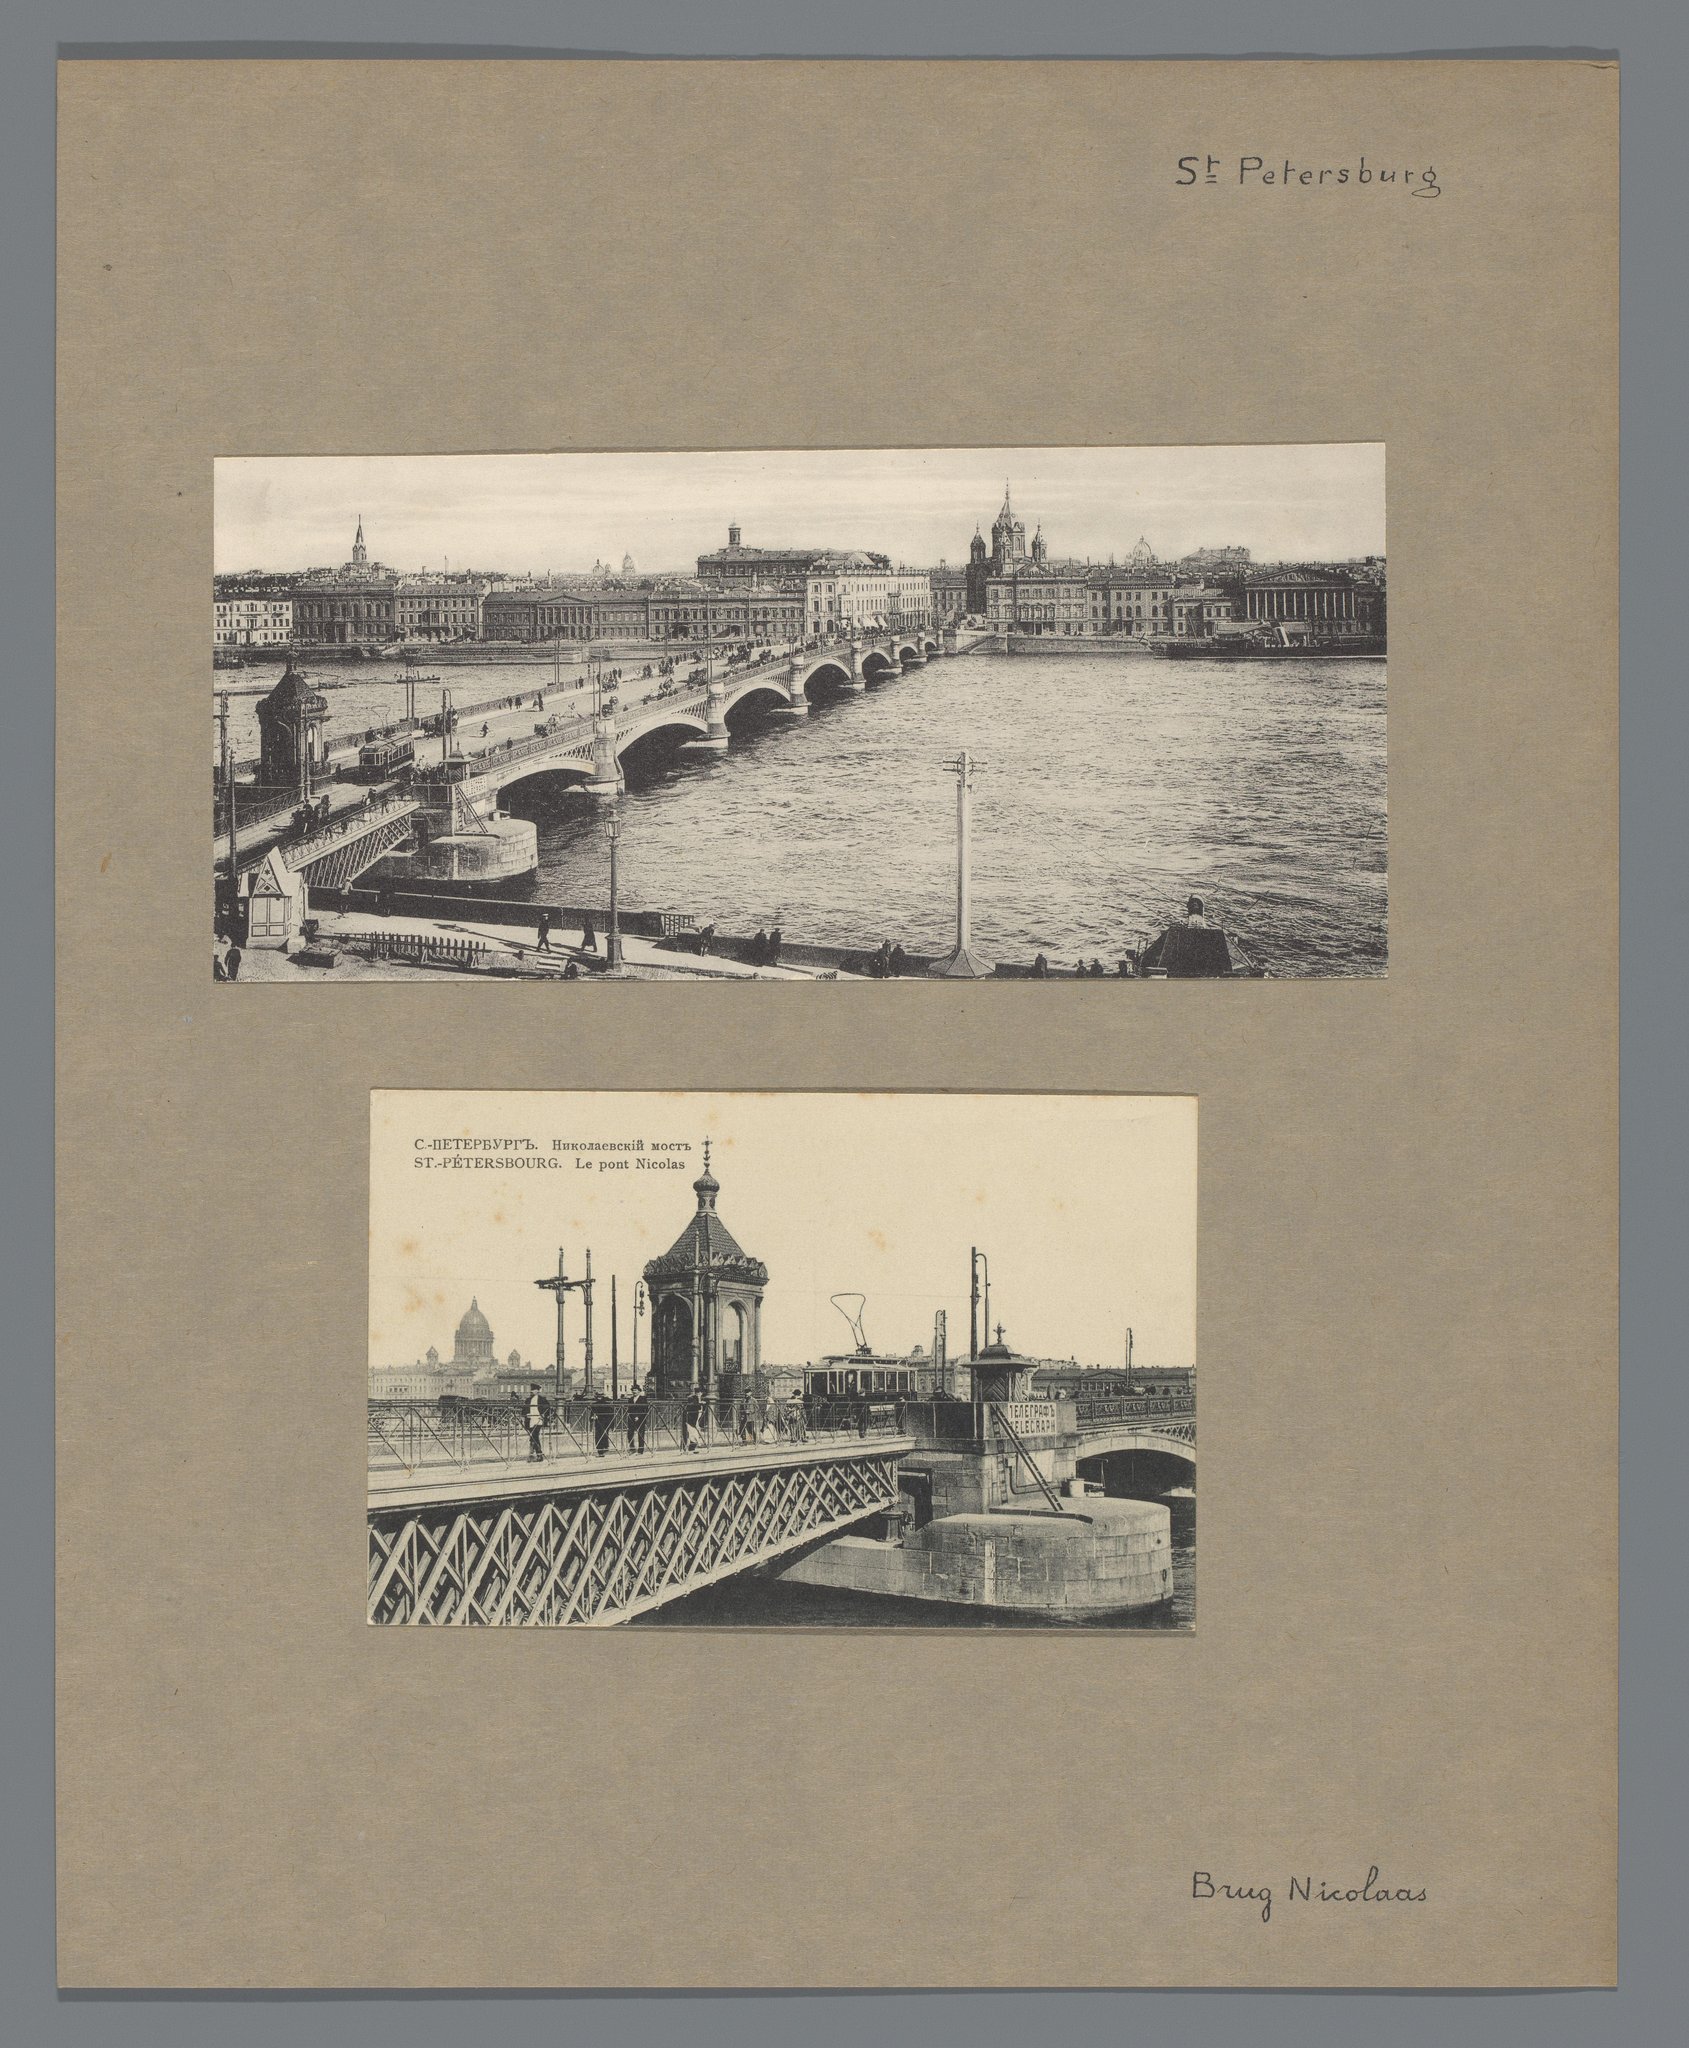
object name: photograph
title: St. Petersburg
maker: Anonymous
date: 1860-1925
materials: photographic support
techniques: photograph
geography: russia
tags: sint-petersburg